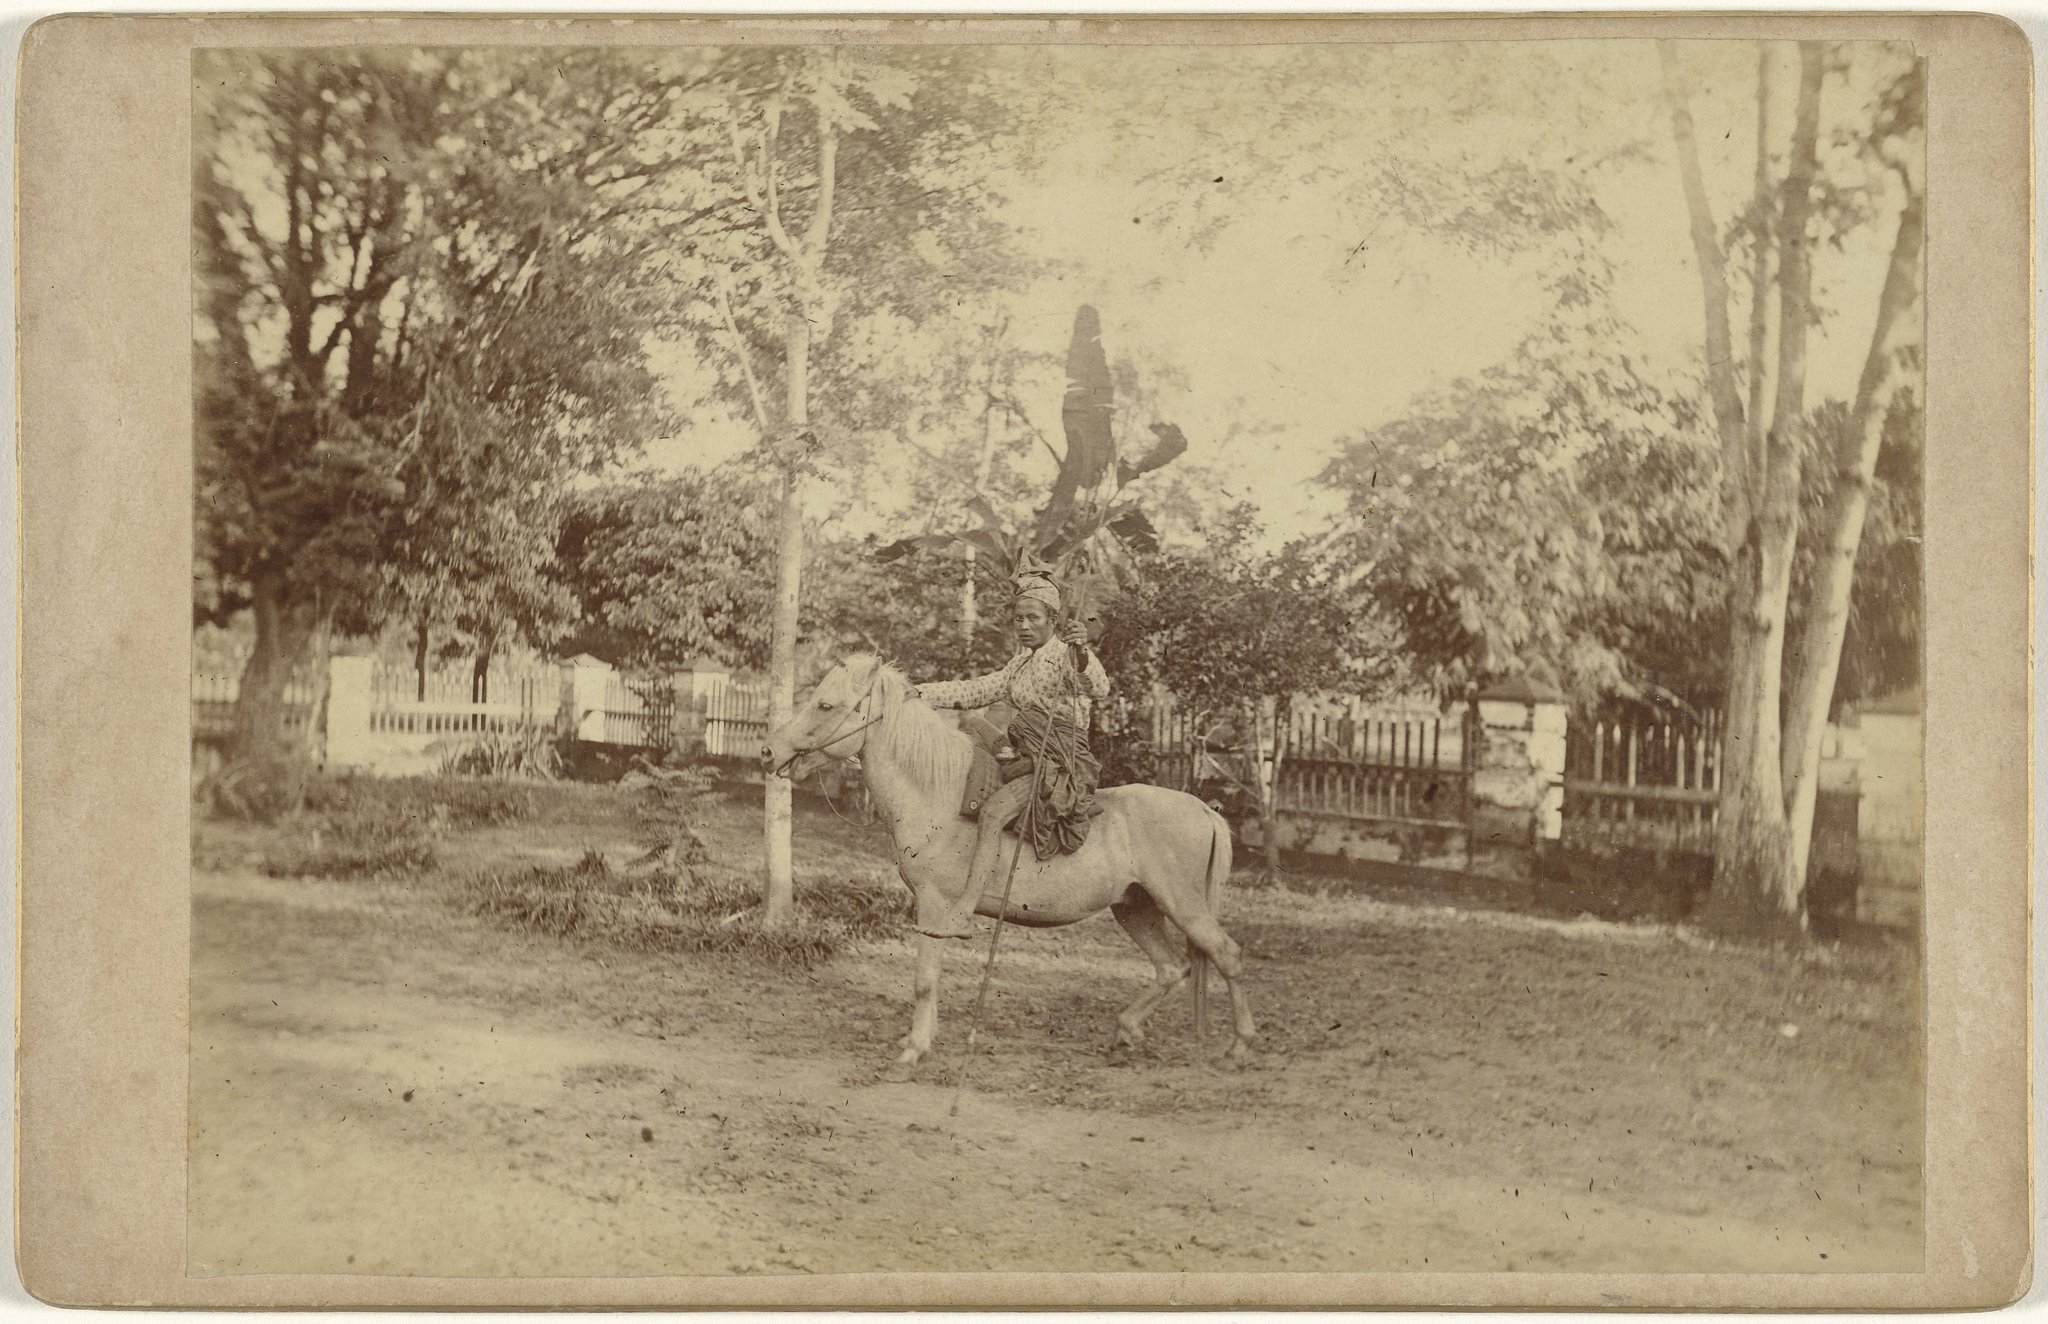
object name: cabinet photograph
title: Buginesische Hirschjäger (Celebes)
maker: Anonymous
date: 1870-1900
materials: cardboard, paper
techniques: albumen print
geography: sulawesi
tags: riding a horse, ass, or mule; rider, horseman, hunter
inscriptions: inscription: ‘Buginesischer Hinschjäger/ (Celebes)’